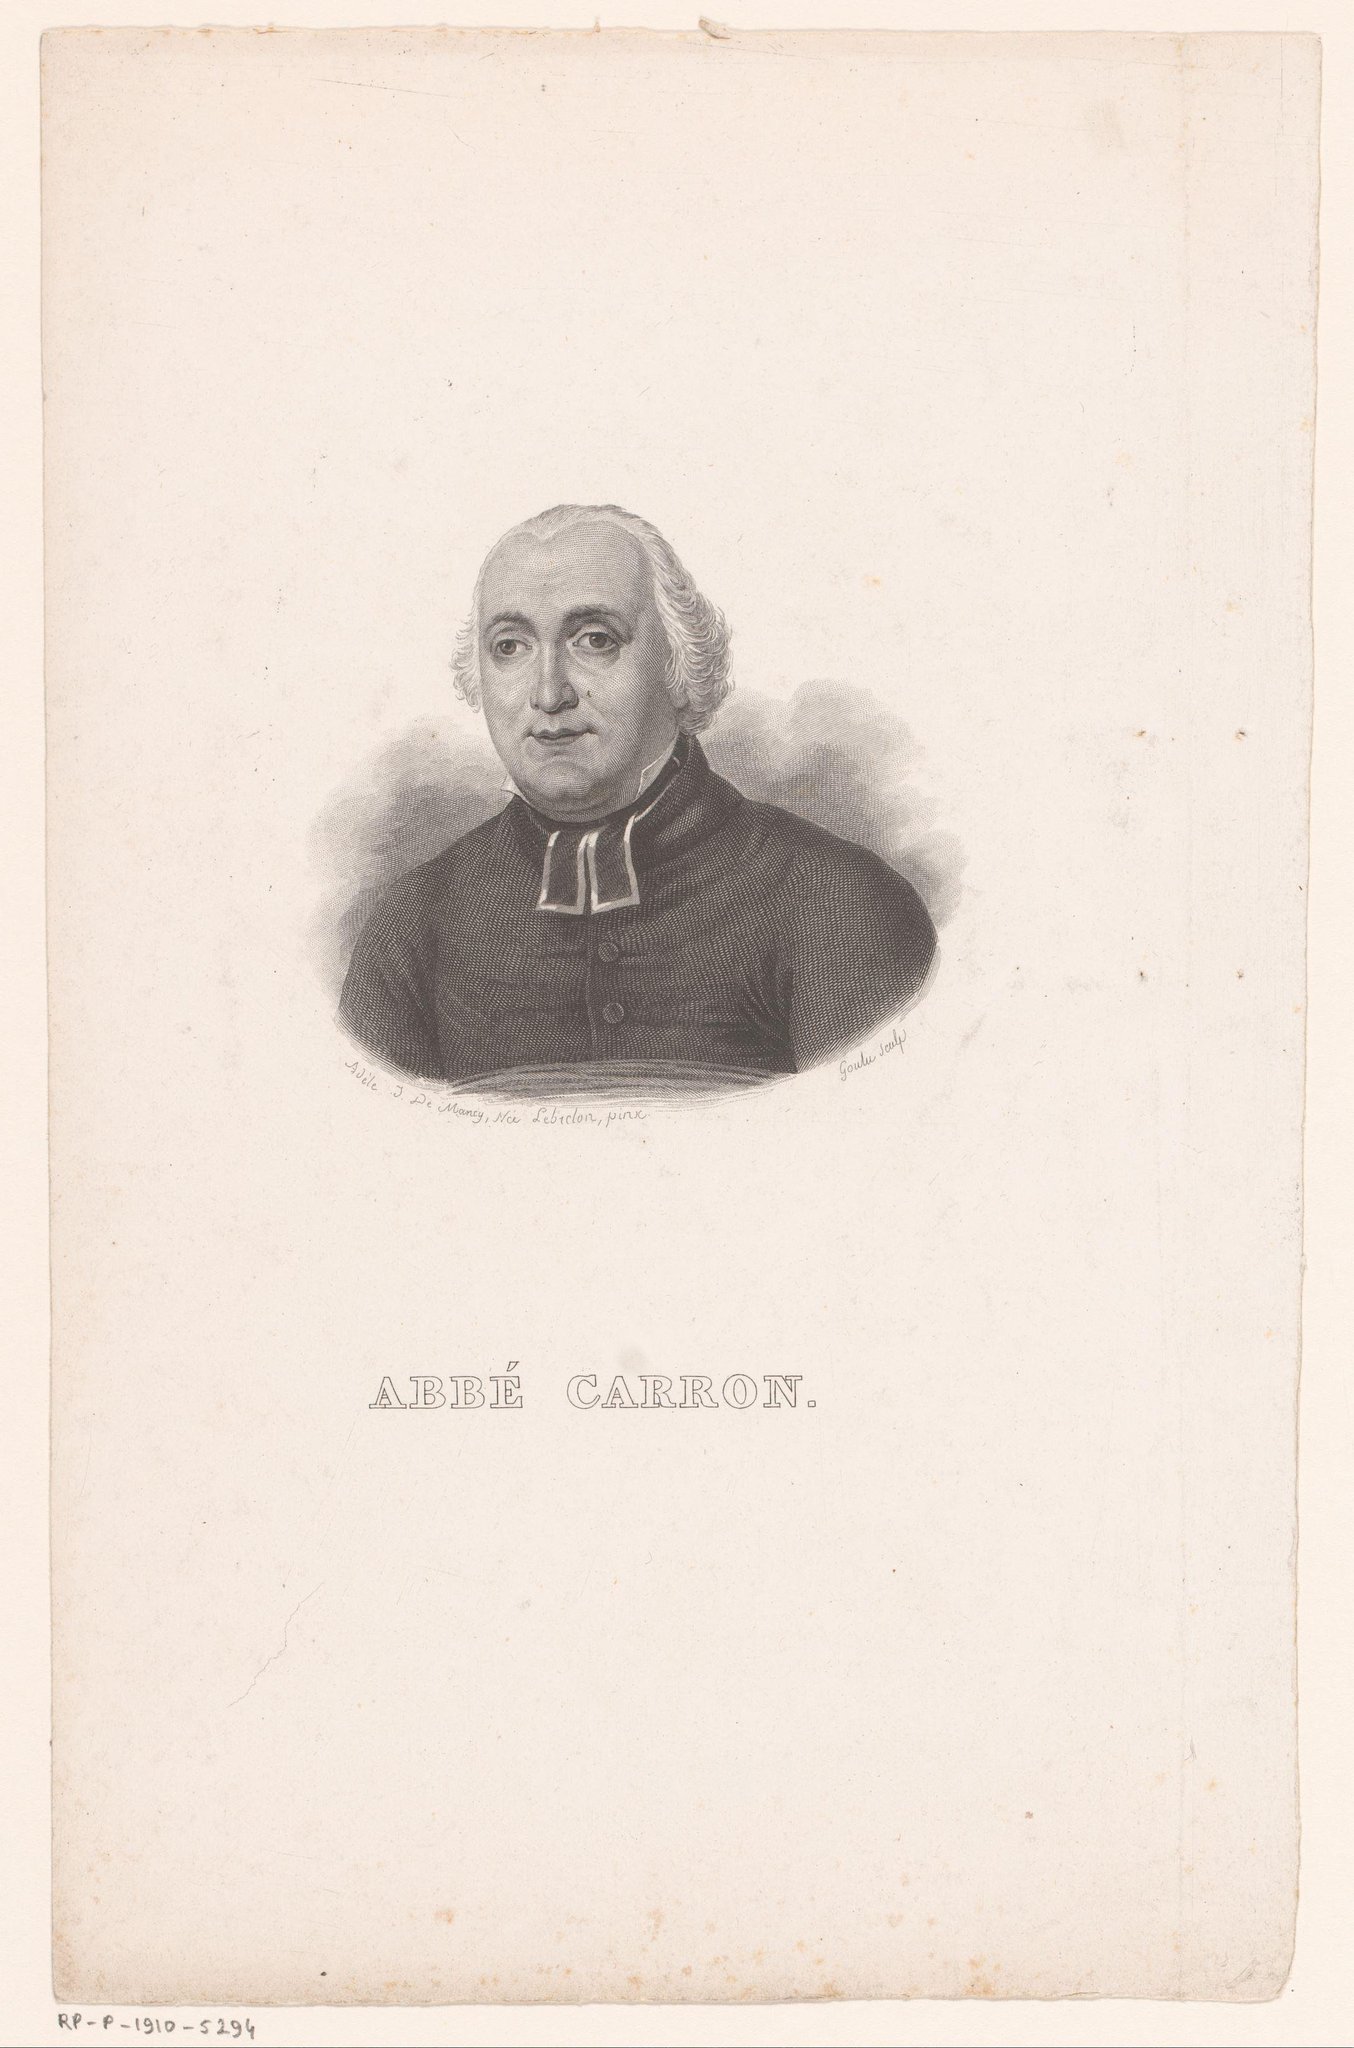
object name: print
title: Abbé Carro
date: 1825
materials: paper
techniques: engraving, etching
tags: paris, priest, historical persons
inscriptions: collector's mark: Lugt 2228